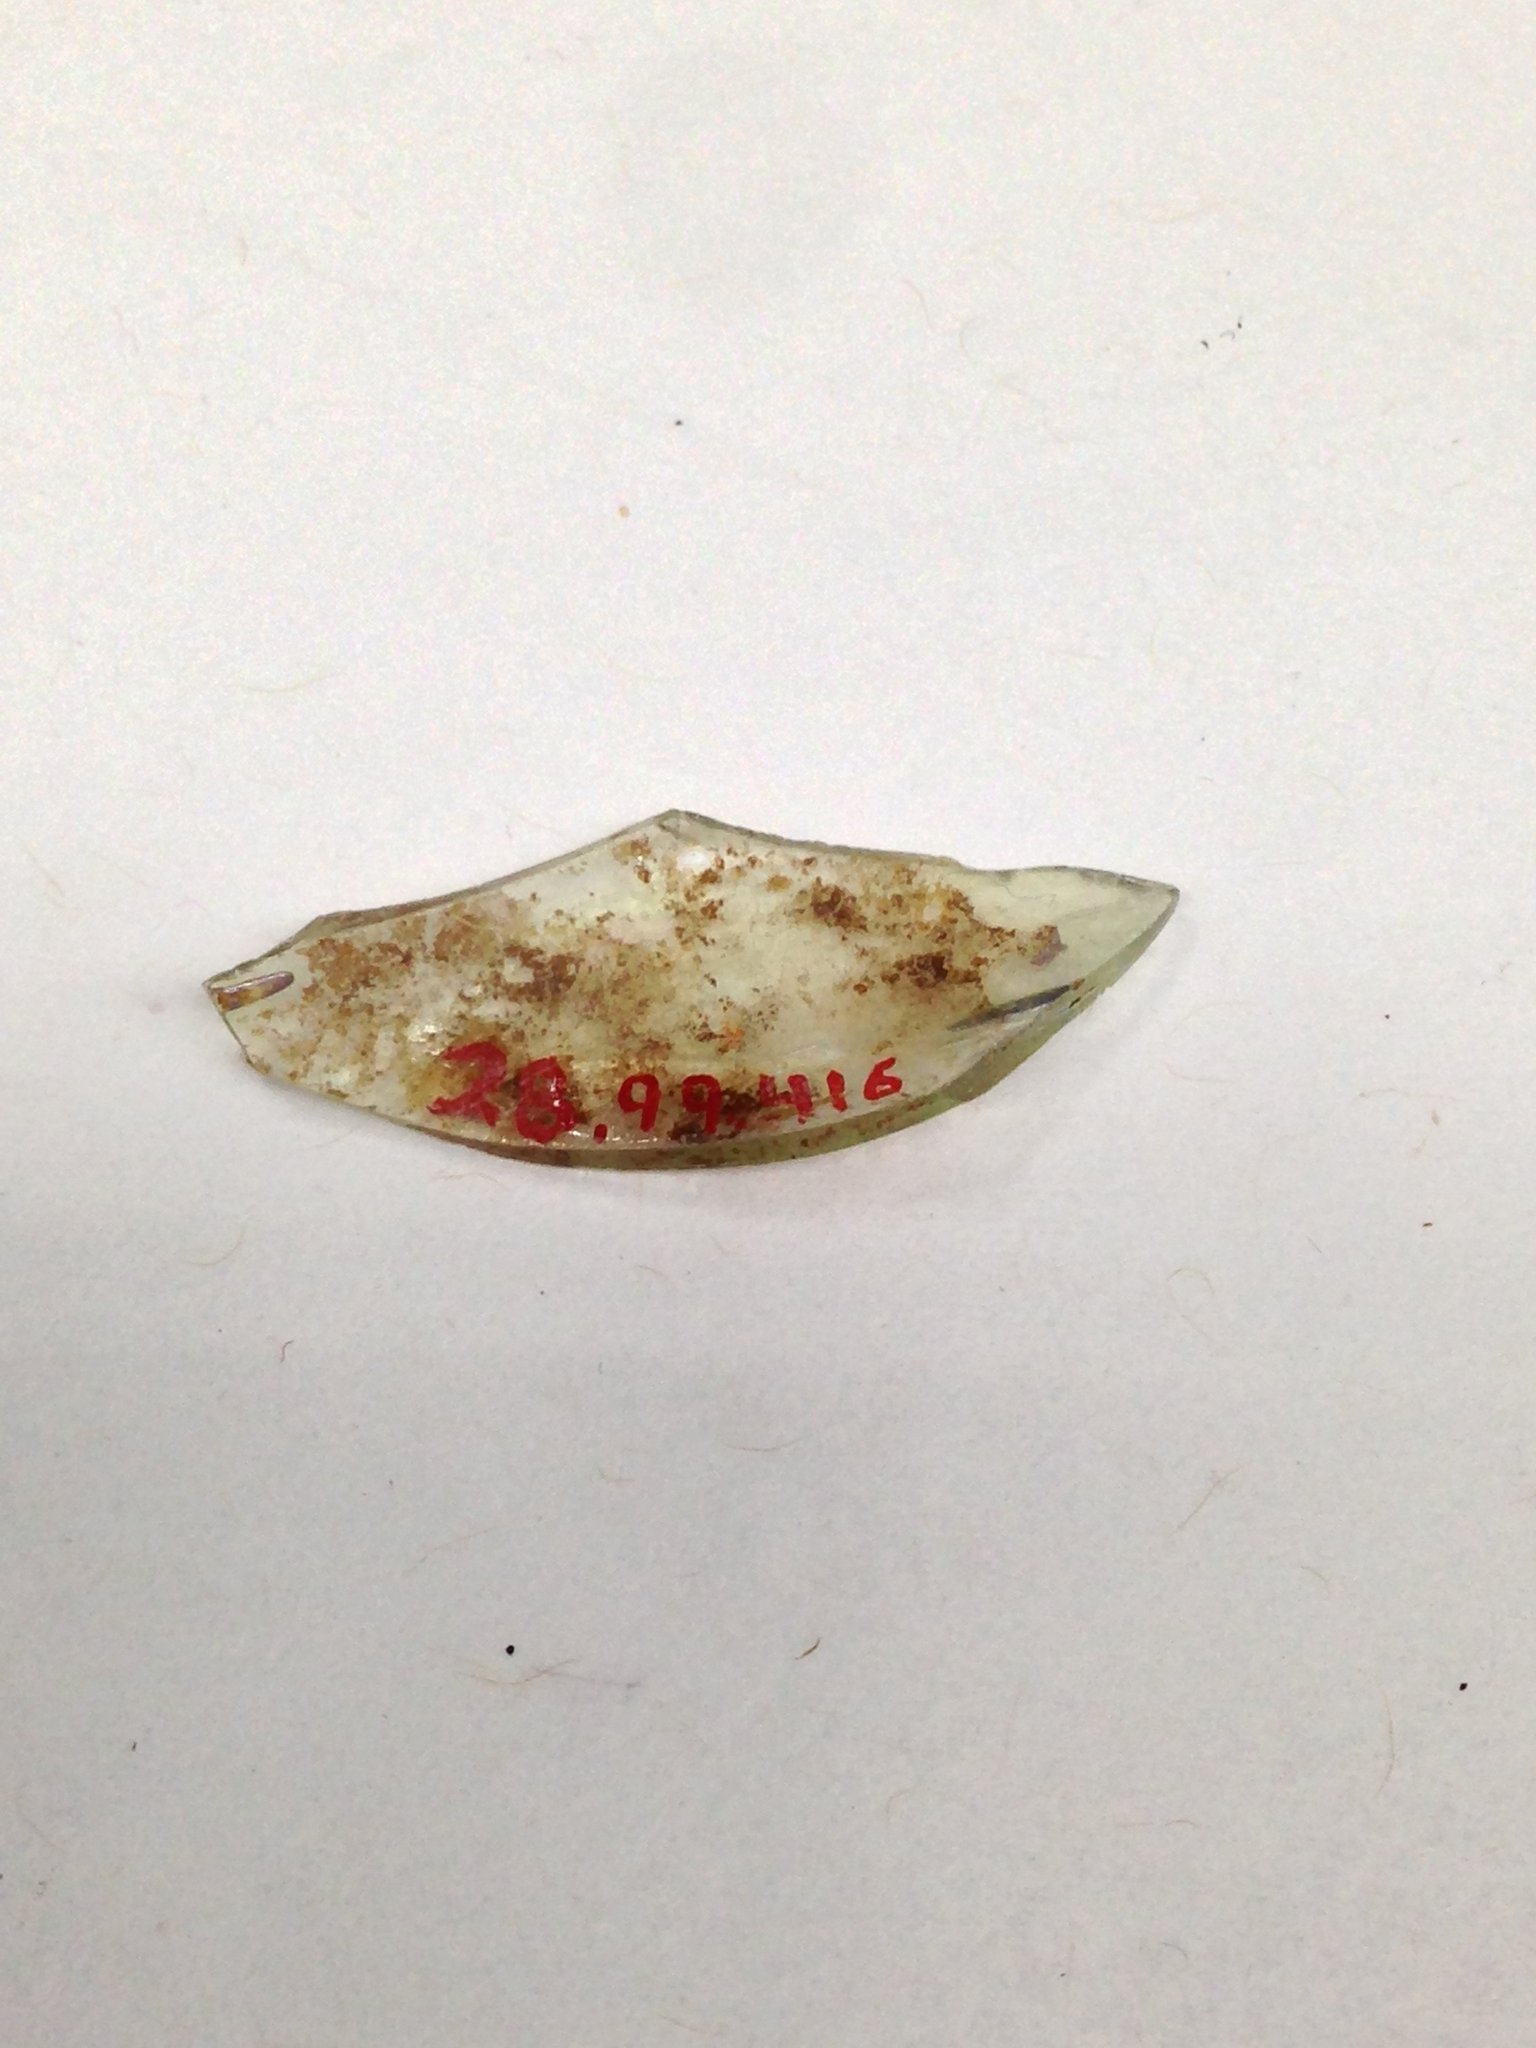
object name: fragment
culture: european or middle eastern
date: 1150-1250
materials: ceramic, glass